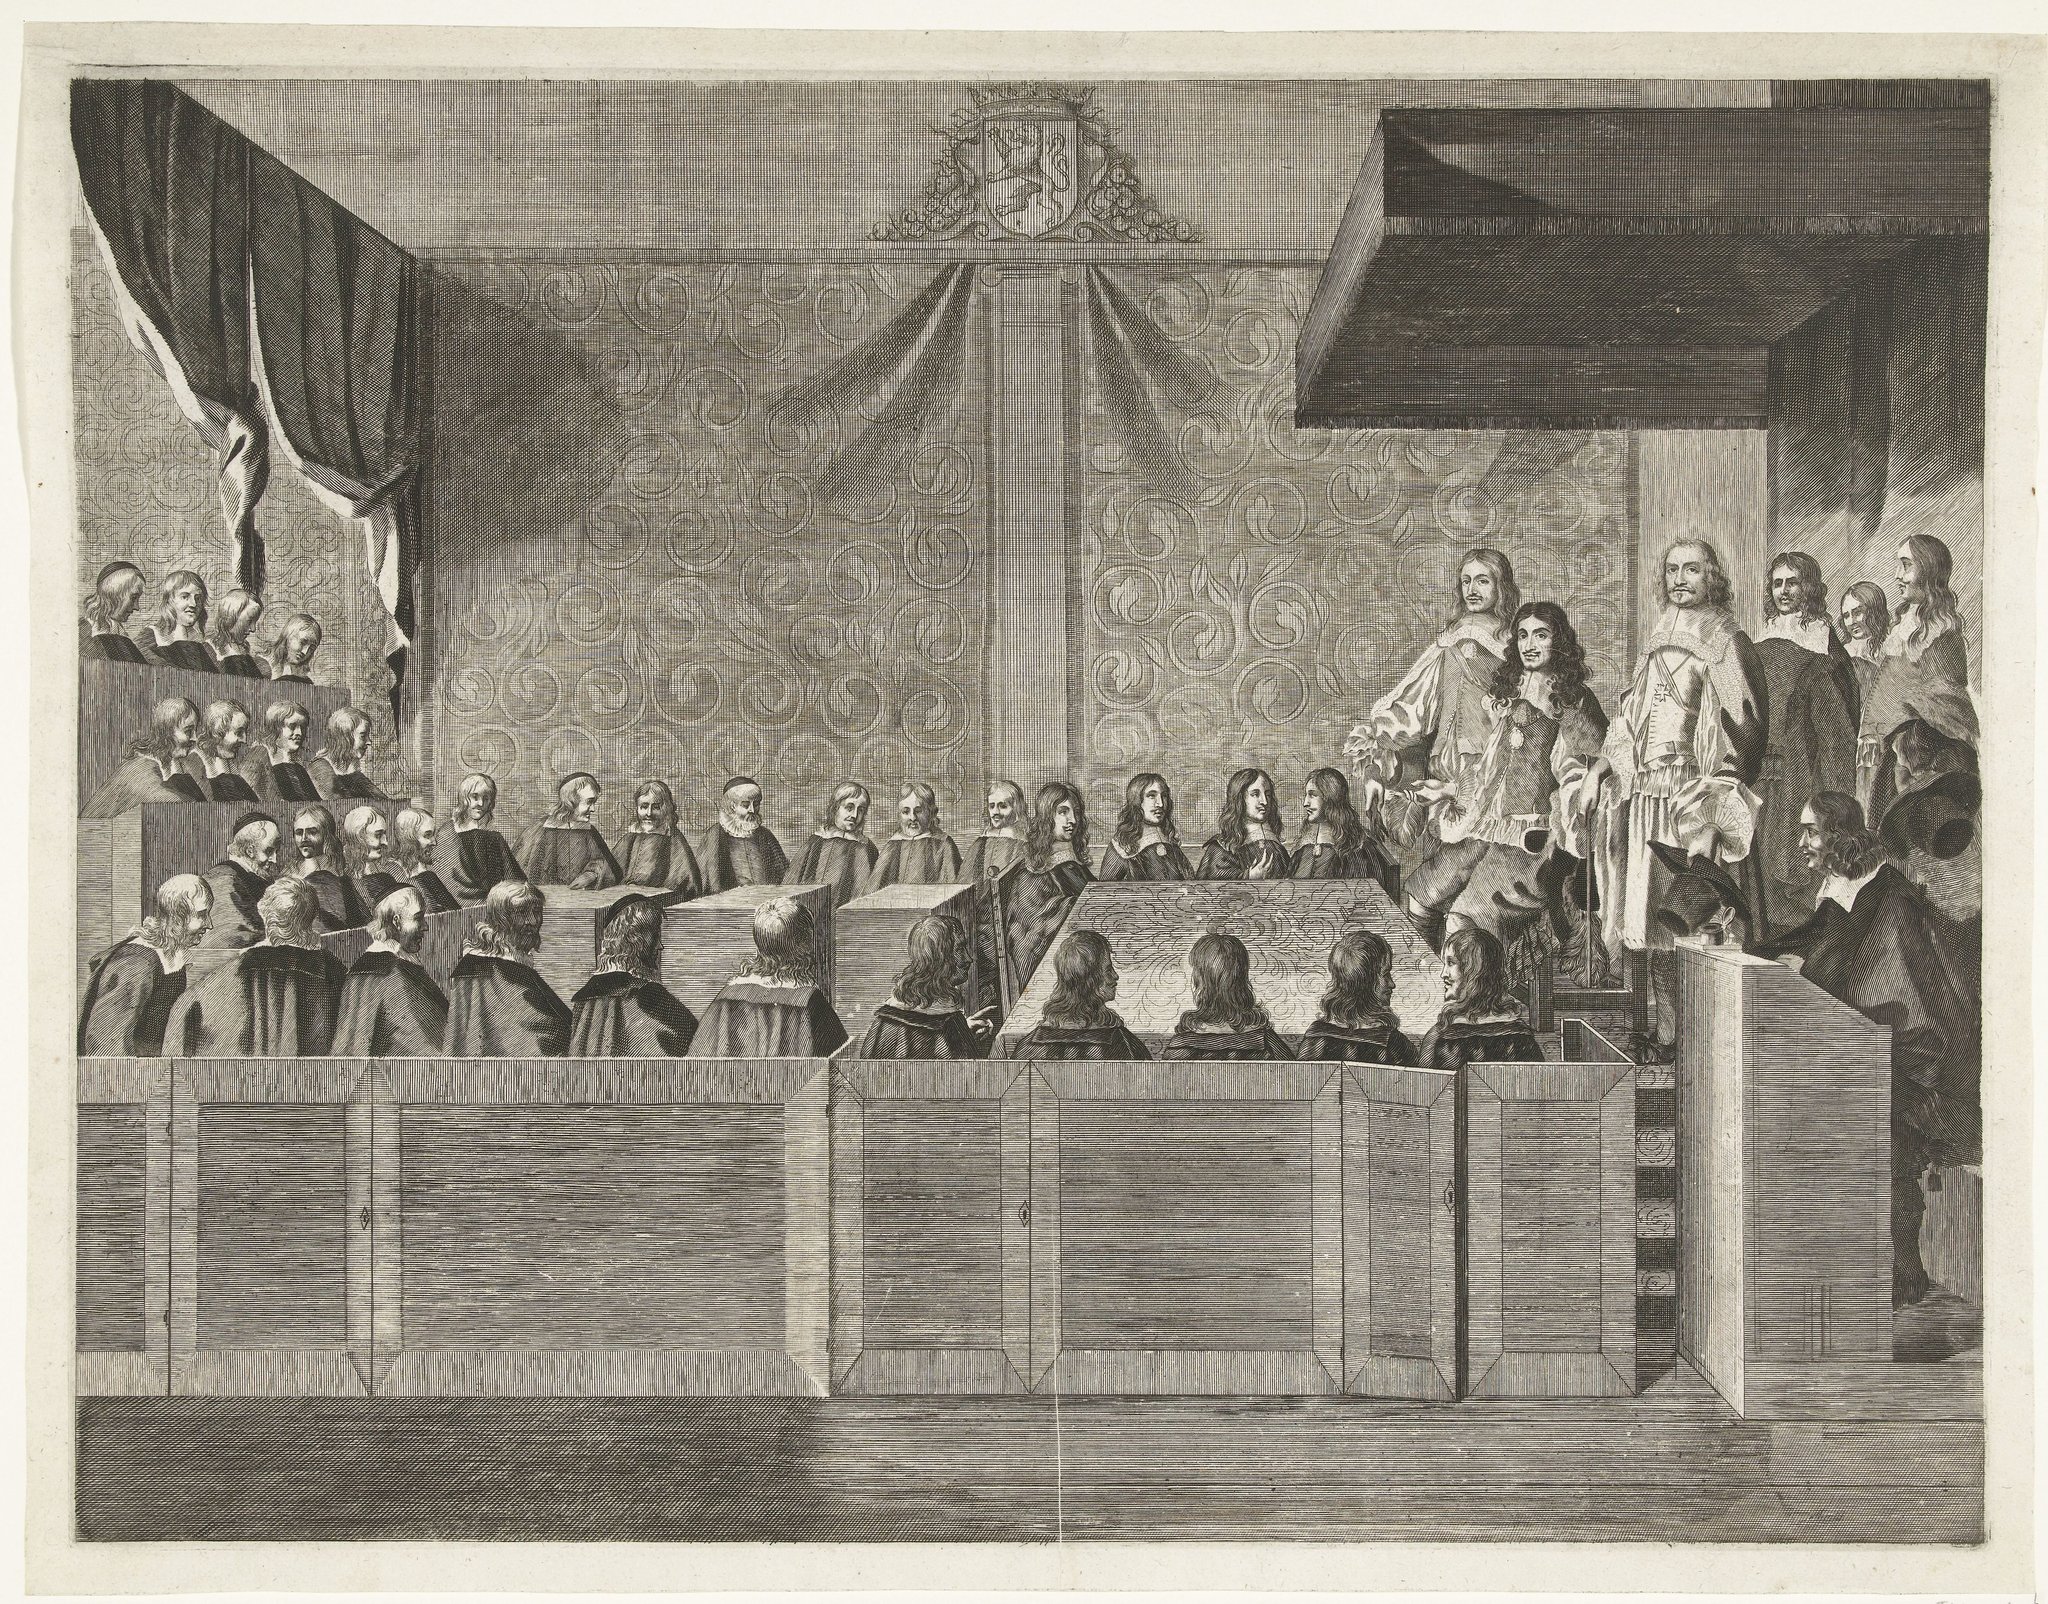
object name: print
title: Koning Karel II van Engeland spreekt de zittende leden van de Staten-Generaal toe, 1660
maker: pieter philippe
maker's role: print maker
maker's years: 1635-1702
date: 1660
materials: paper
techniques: engraving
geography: northern netherlands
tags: london, karel ii (koning van engeland), festivities (+ speech, address ~ festive activities)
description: Koning Karel II van Engeland spreekt de Staten-Generaal toe, 1 juni 1660. Episode tijdens zijn rondreis door en vertrek uit de Nederlanden. De koning rechts met begeleiders zittend onder een baldakijn, met de voeten onder de tafel van de op een gesloten zitbank zittende raadsheren. Met vele andere gezichten, op de muur het wapen van Holland.